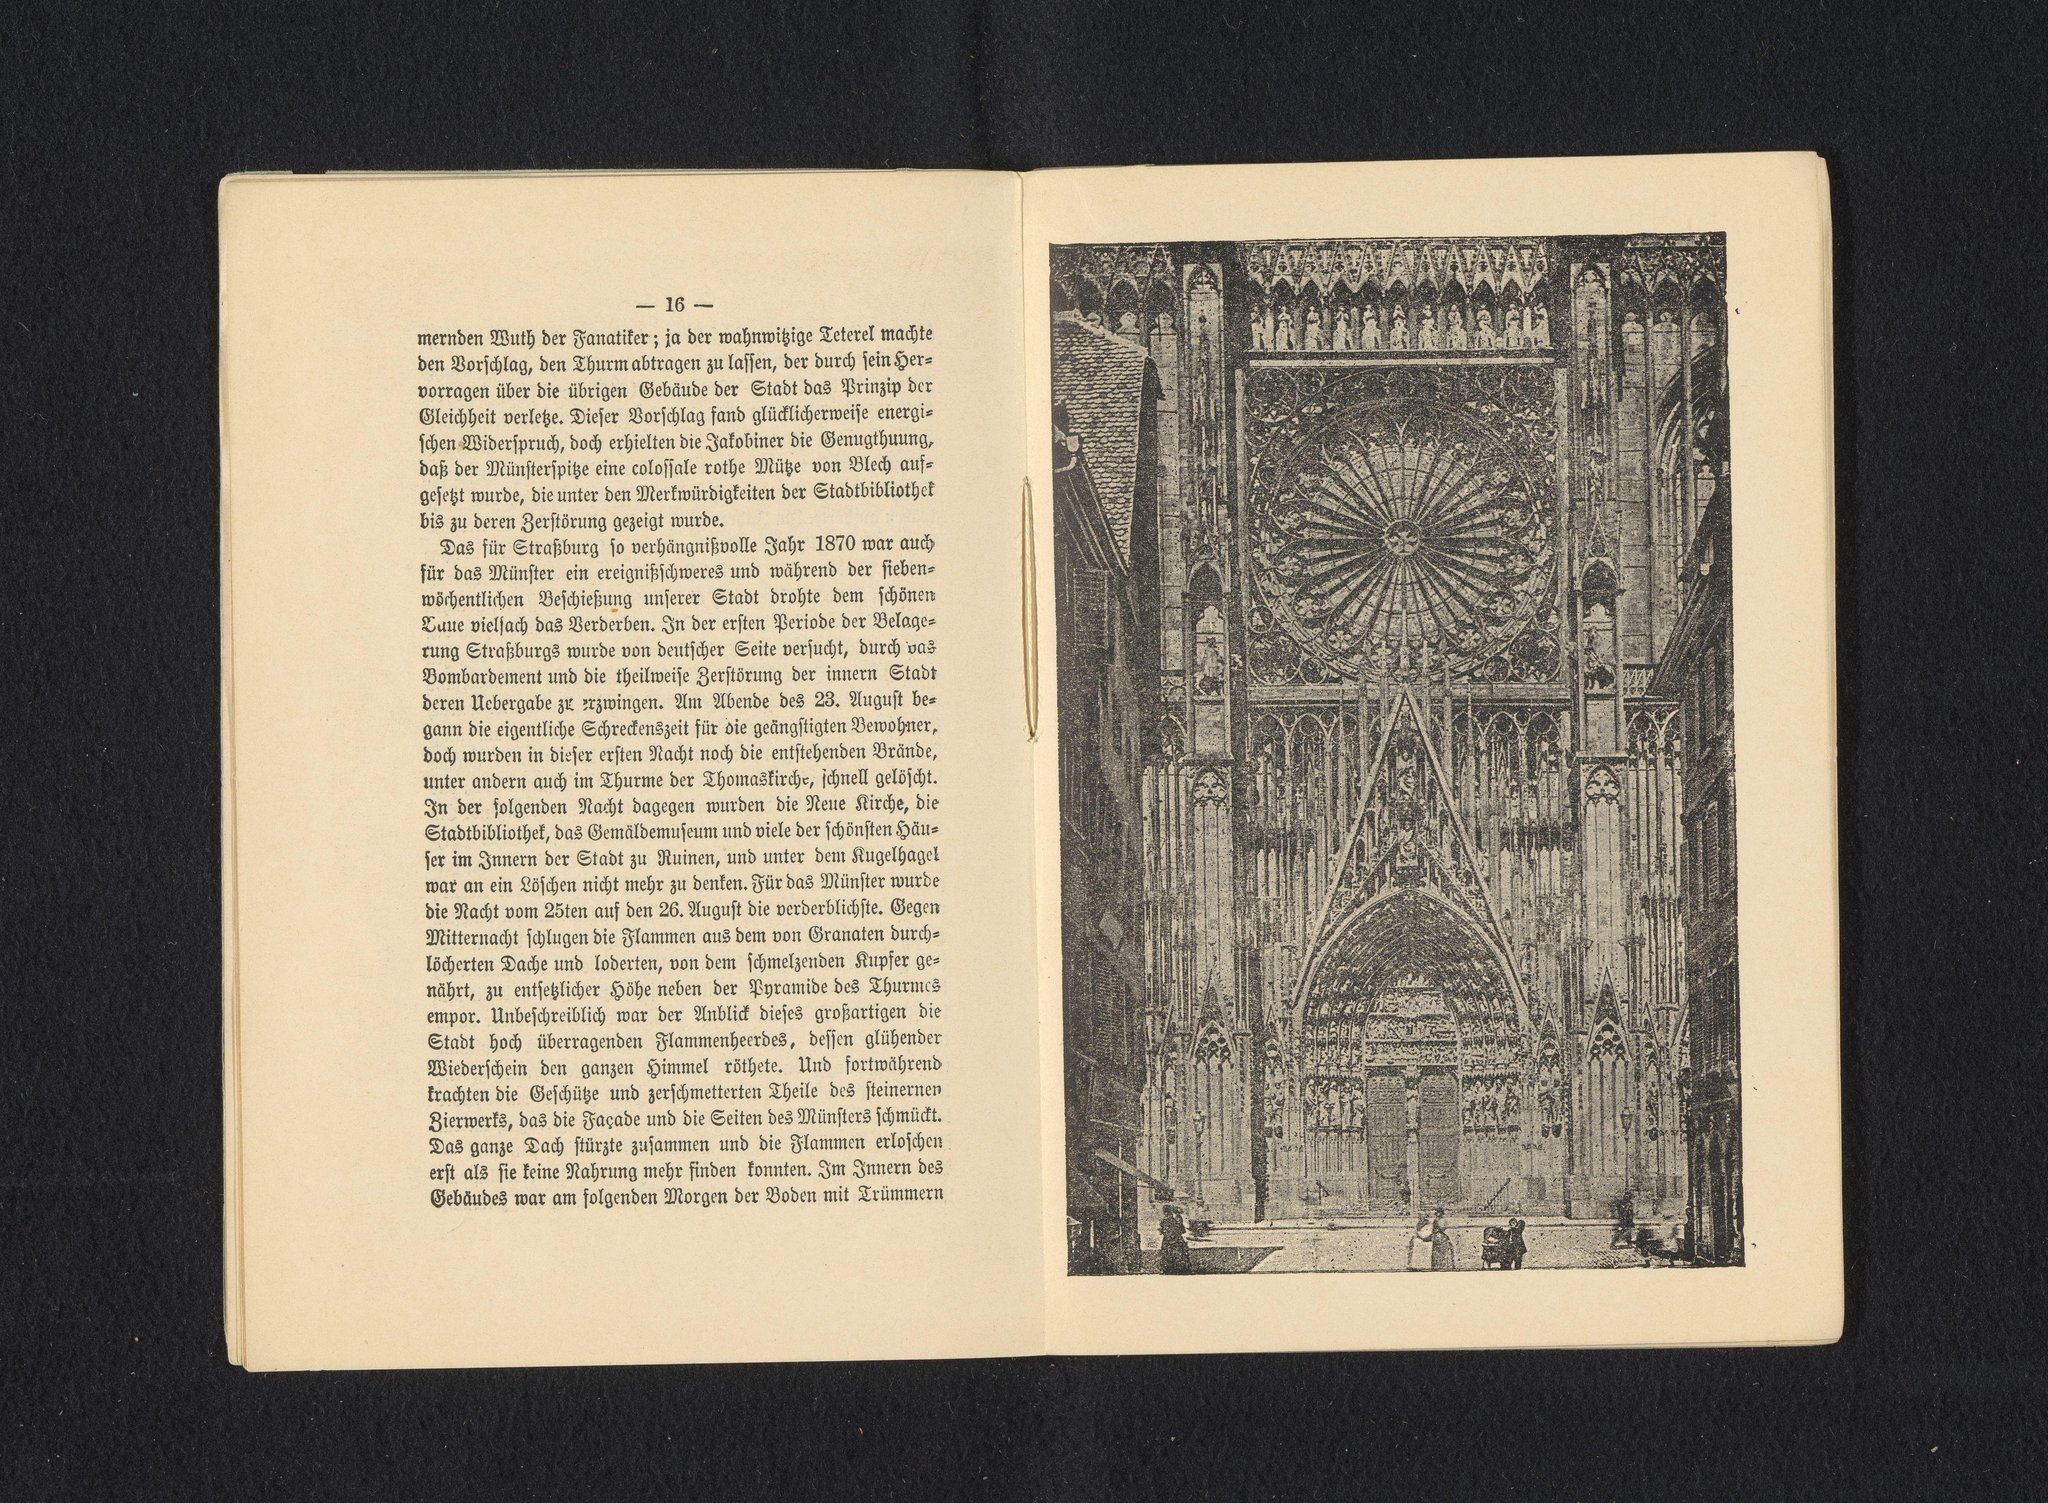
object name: photomechanical print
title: Gezicht op de deuren met archivolt en het roos venster van de Kathedraal van Straatsburg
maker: Anonymous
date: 1897-1902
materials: paper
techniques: autotype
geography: straatsburg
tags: church-window, e.g. rose-window, arch, archivolt ~ architecture